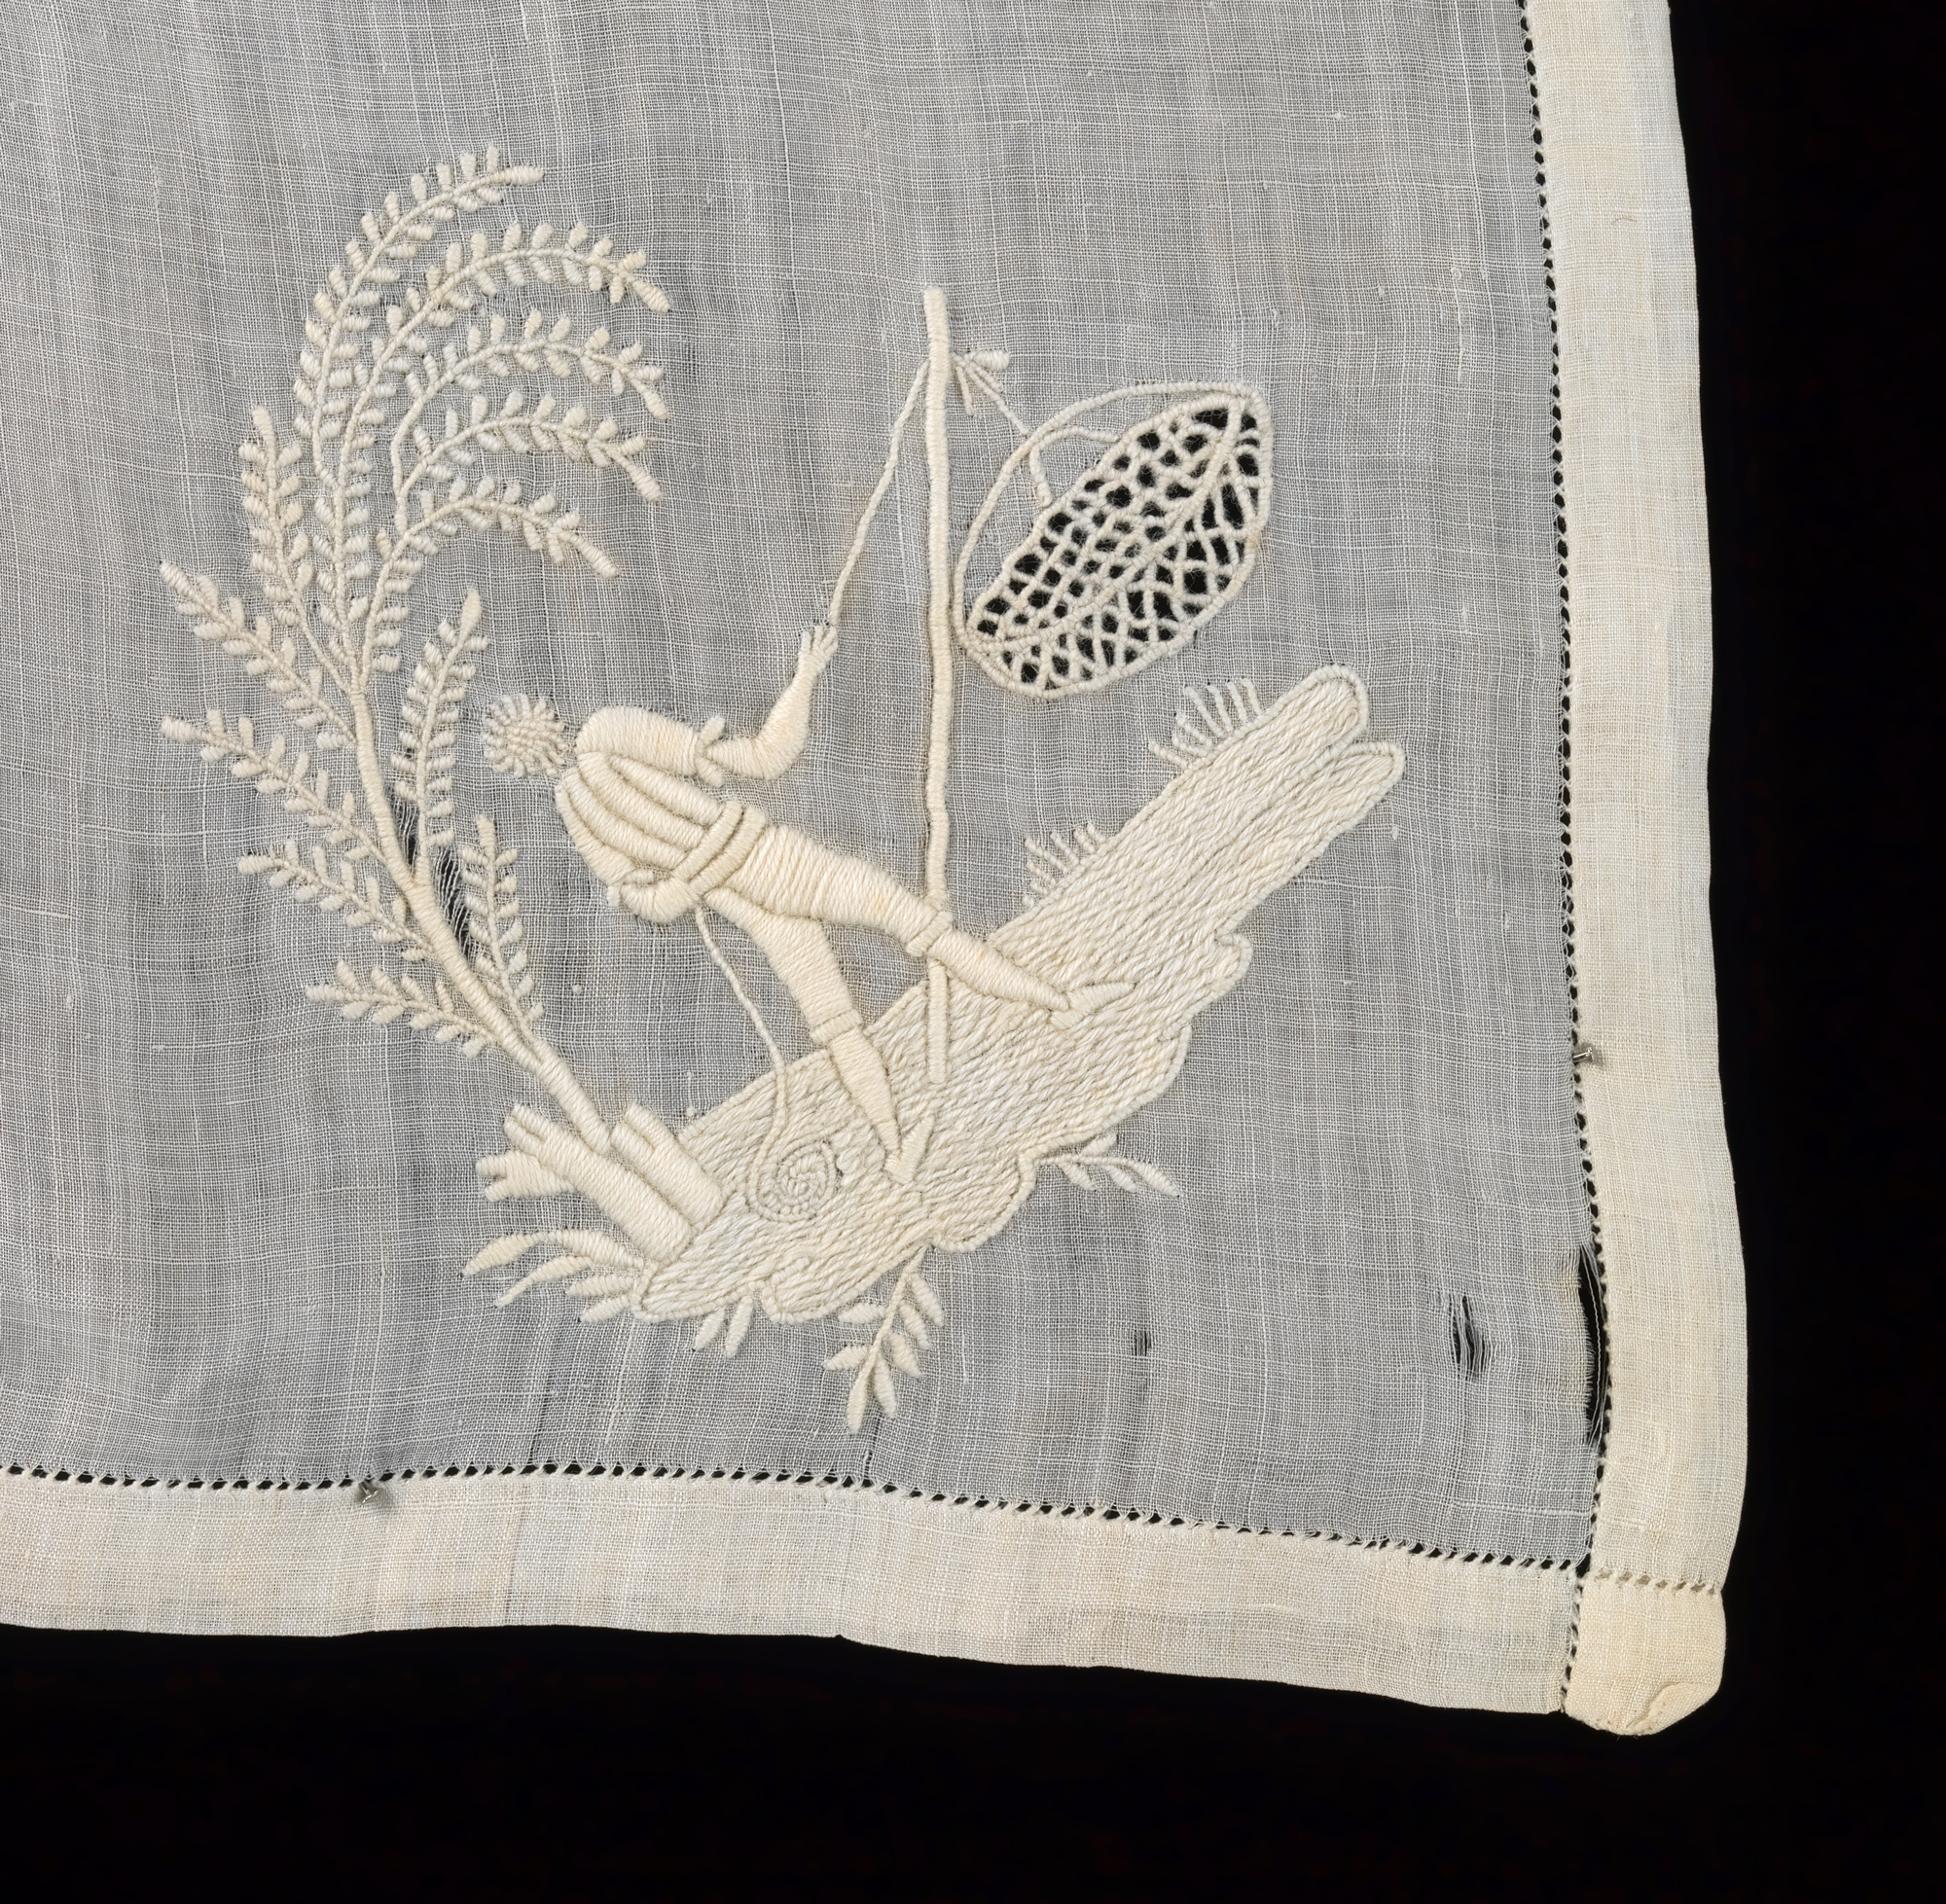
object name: handkerchief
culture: french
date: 1867-1900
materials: linen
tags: men,fishing,hunting,boats